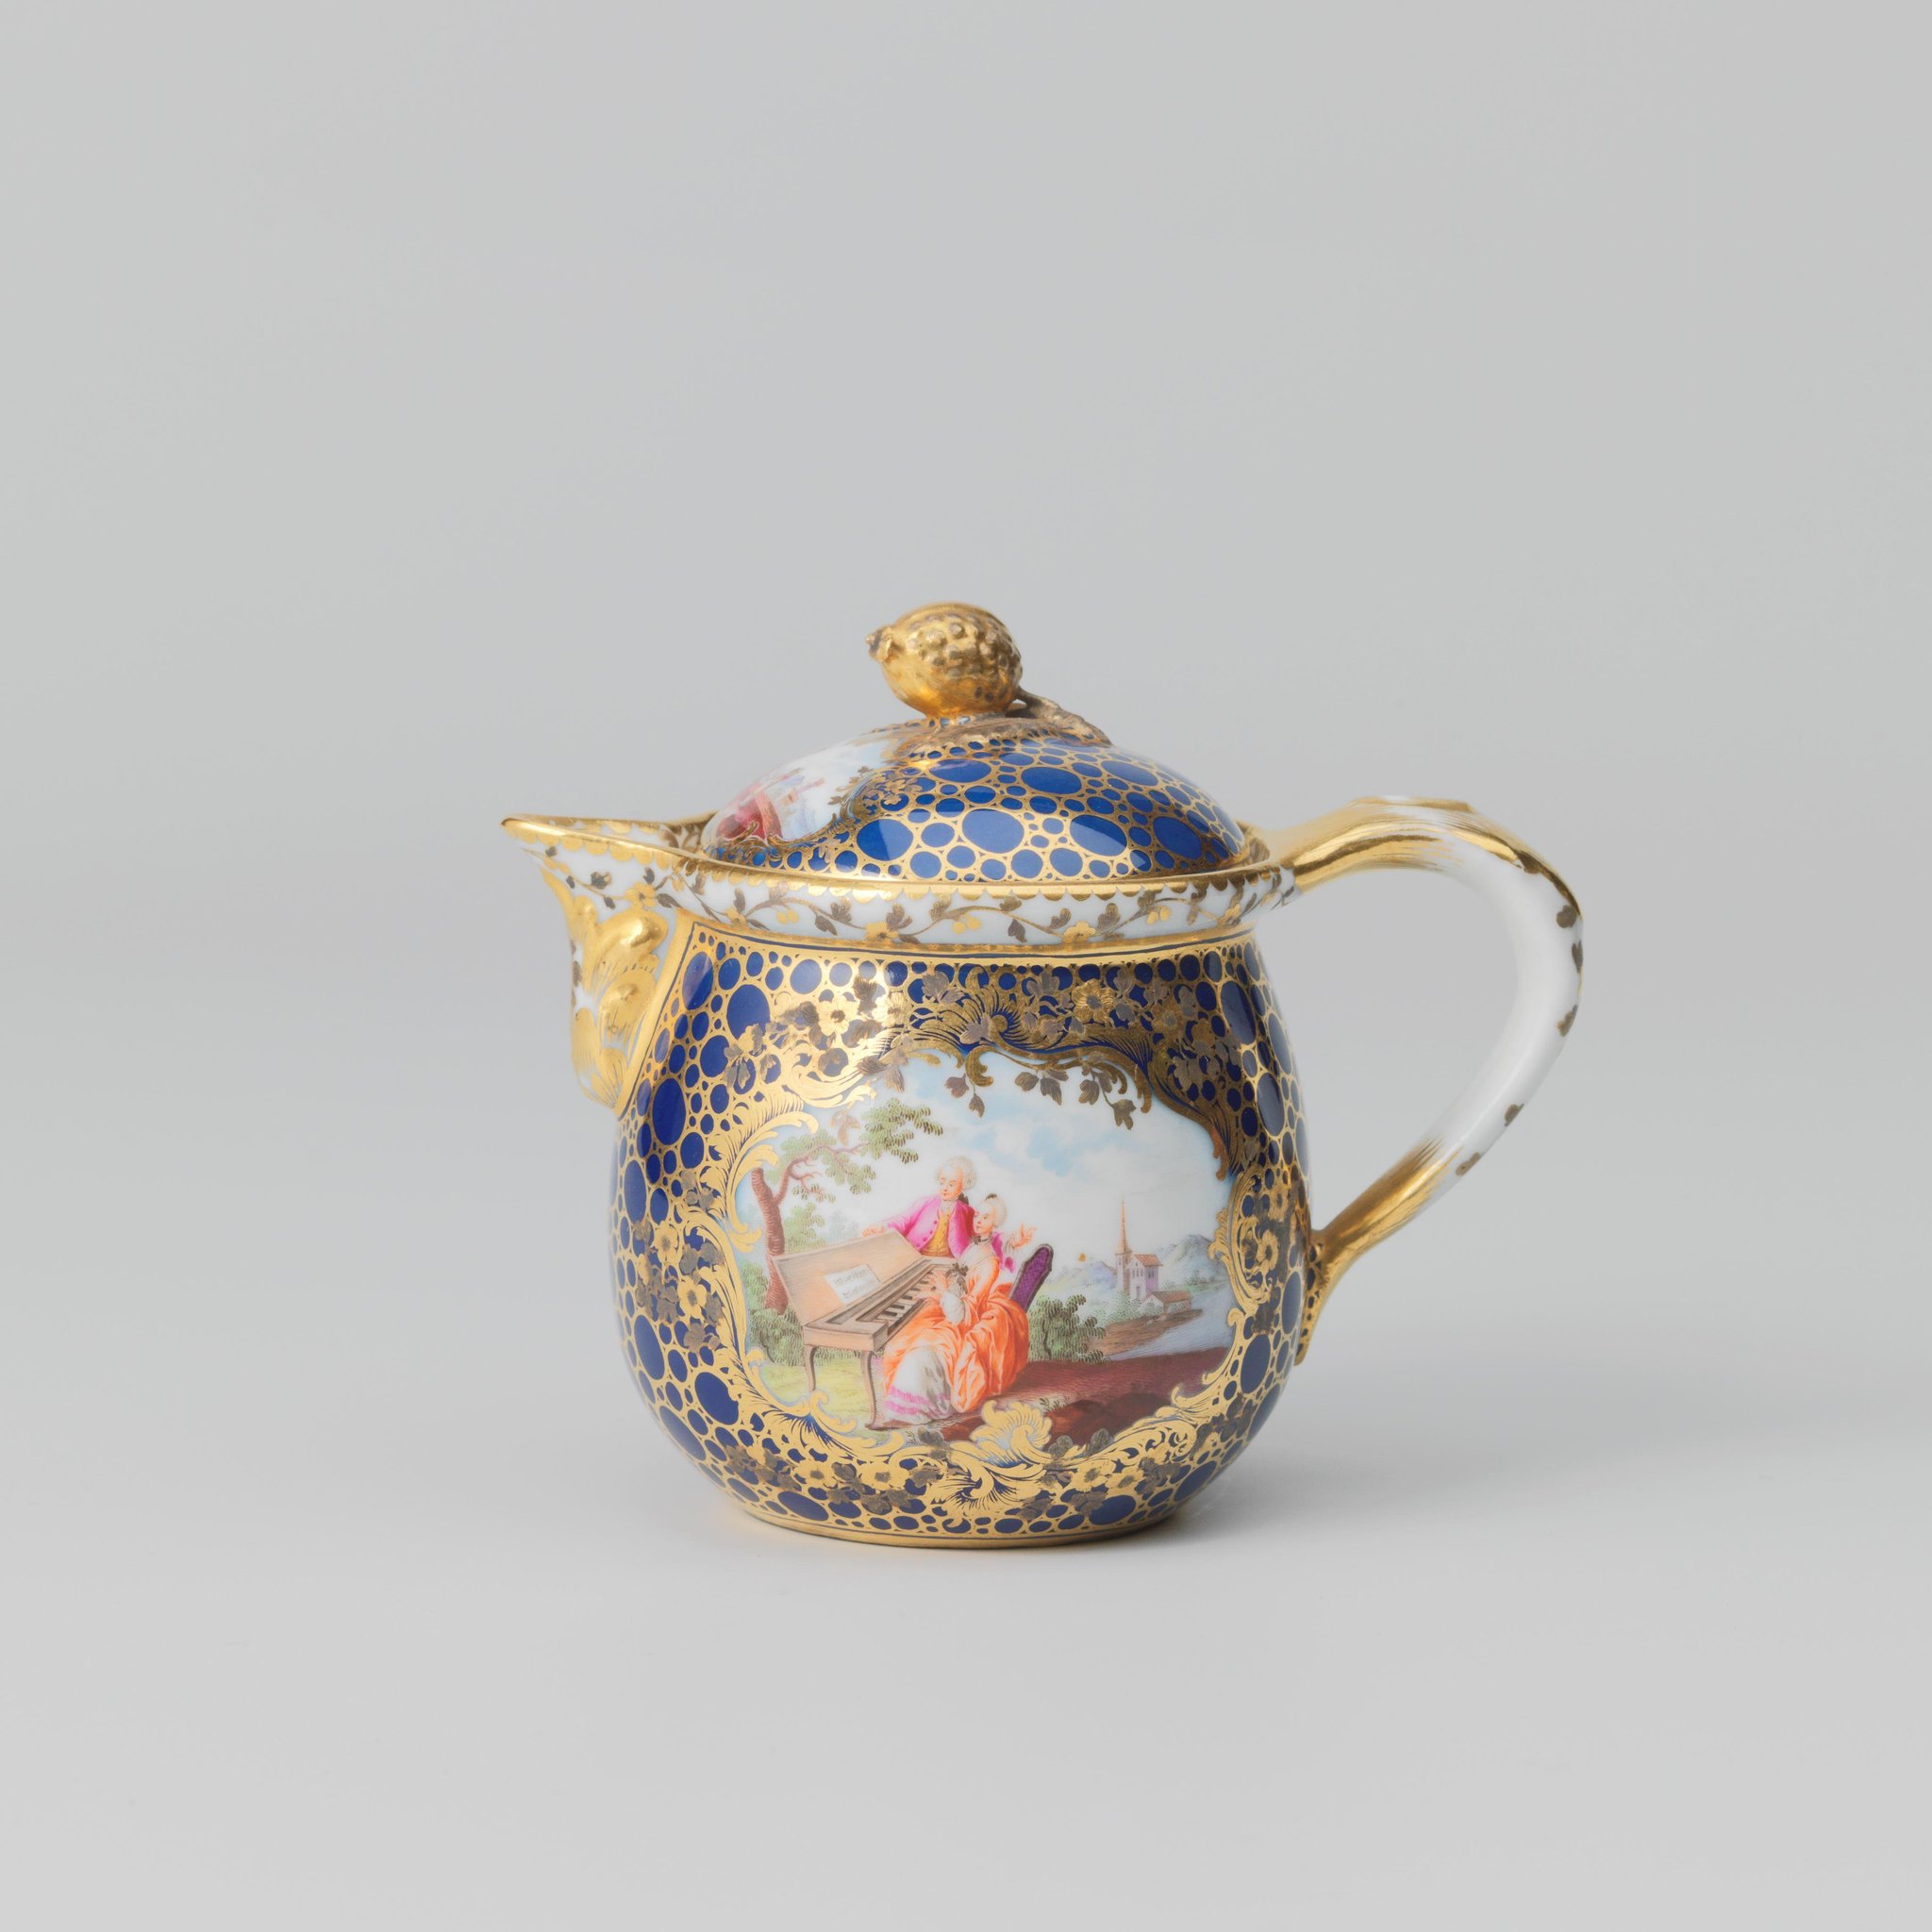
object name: milk jug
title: Milk jug with a couple in a landscape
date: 1765-1770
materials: glaze, gold, paint, porcelain, silver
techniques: firing, gilding, turning, vitrification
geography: vienna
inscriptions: mark: ‘schild/ N’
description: Melkkan van porselein, beschilderd op het glauur in emailkleuren, zilver[?] en goud. De kan is bedekt met blauw waarover in goud een patroon van cirkels is aangebracht. Hierin uitgespaard tweemaal een rocaille cartouche met daarin een paar in een landschap, de vrouw spelend op een luit of klavecimbel terwijl de man toekijkt of de muziek vashoudt. Het oor, de tuit en de buiten- en binnenrand met bloemranken. Gemerkt op de onderzijde met een vervaagd schild en de letter N.